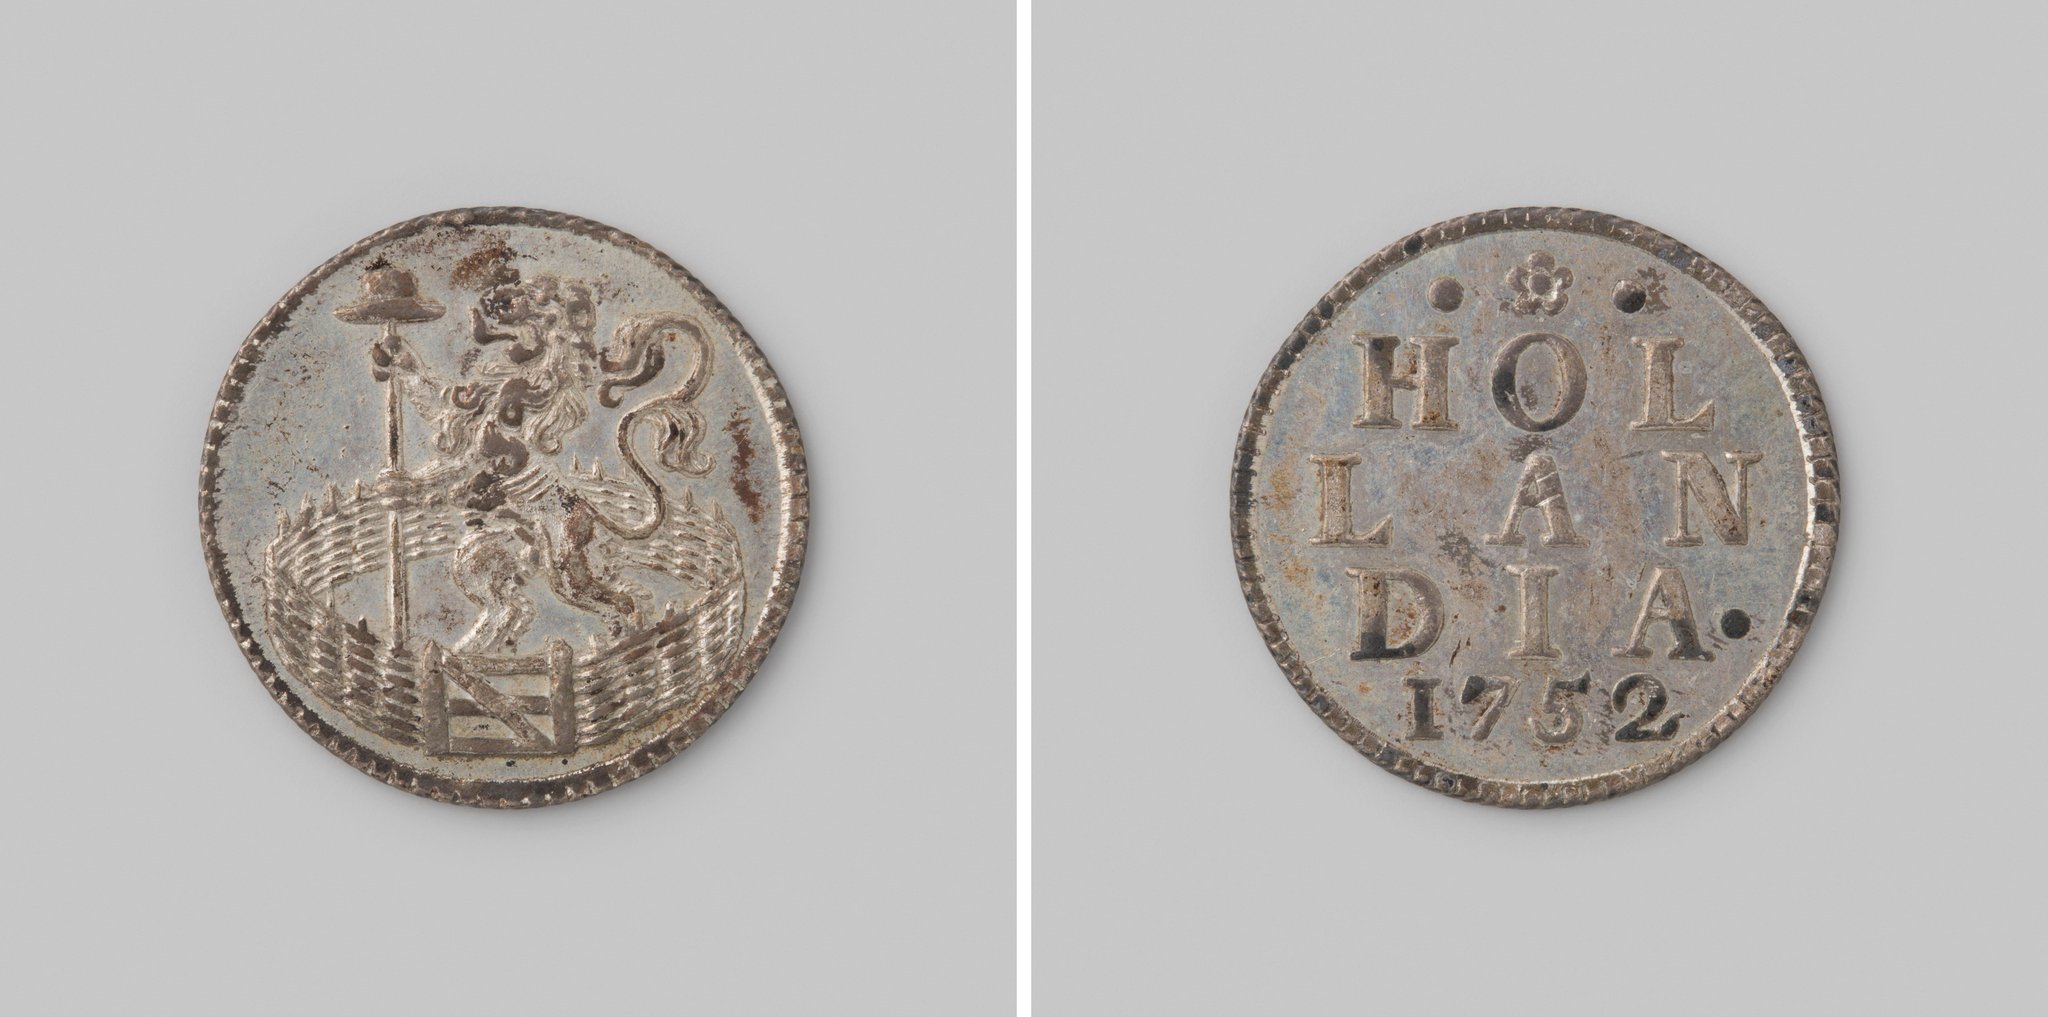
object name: coin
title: Holland, duit,1752. Afslag in zilver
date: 1752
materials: silver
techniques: striking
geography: dordrecht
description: Zilveren munt. Voorzijde: binnen omheining staande leeuw met vrijheidshoed op speer. Keerzijde: opschrift: provincienaam in drie regels, daaronder jaartal. Kabelrand.